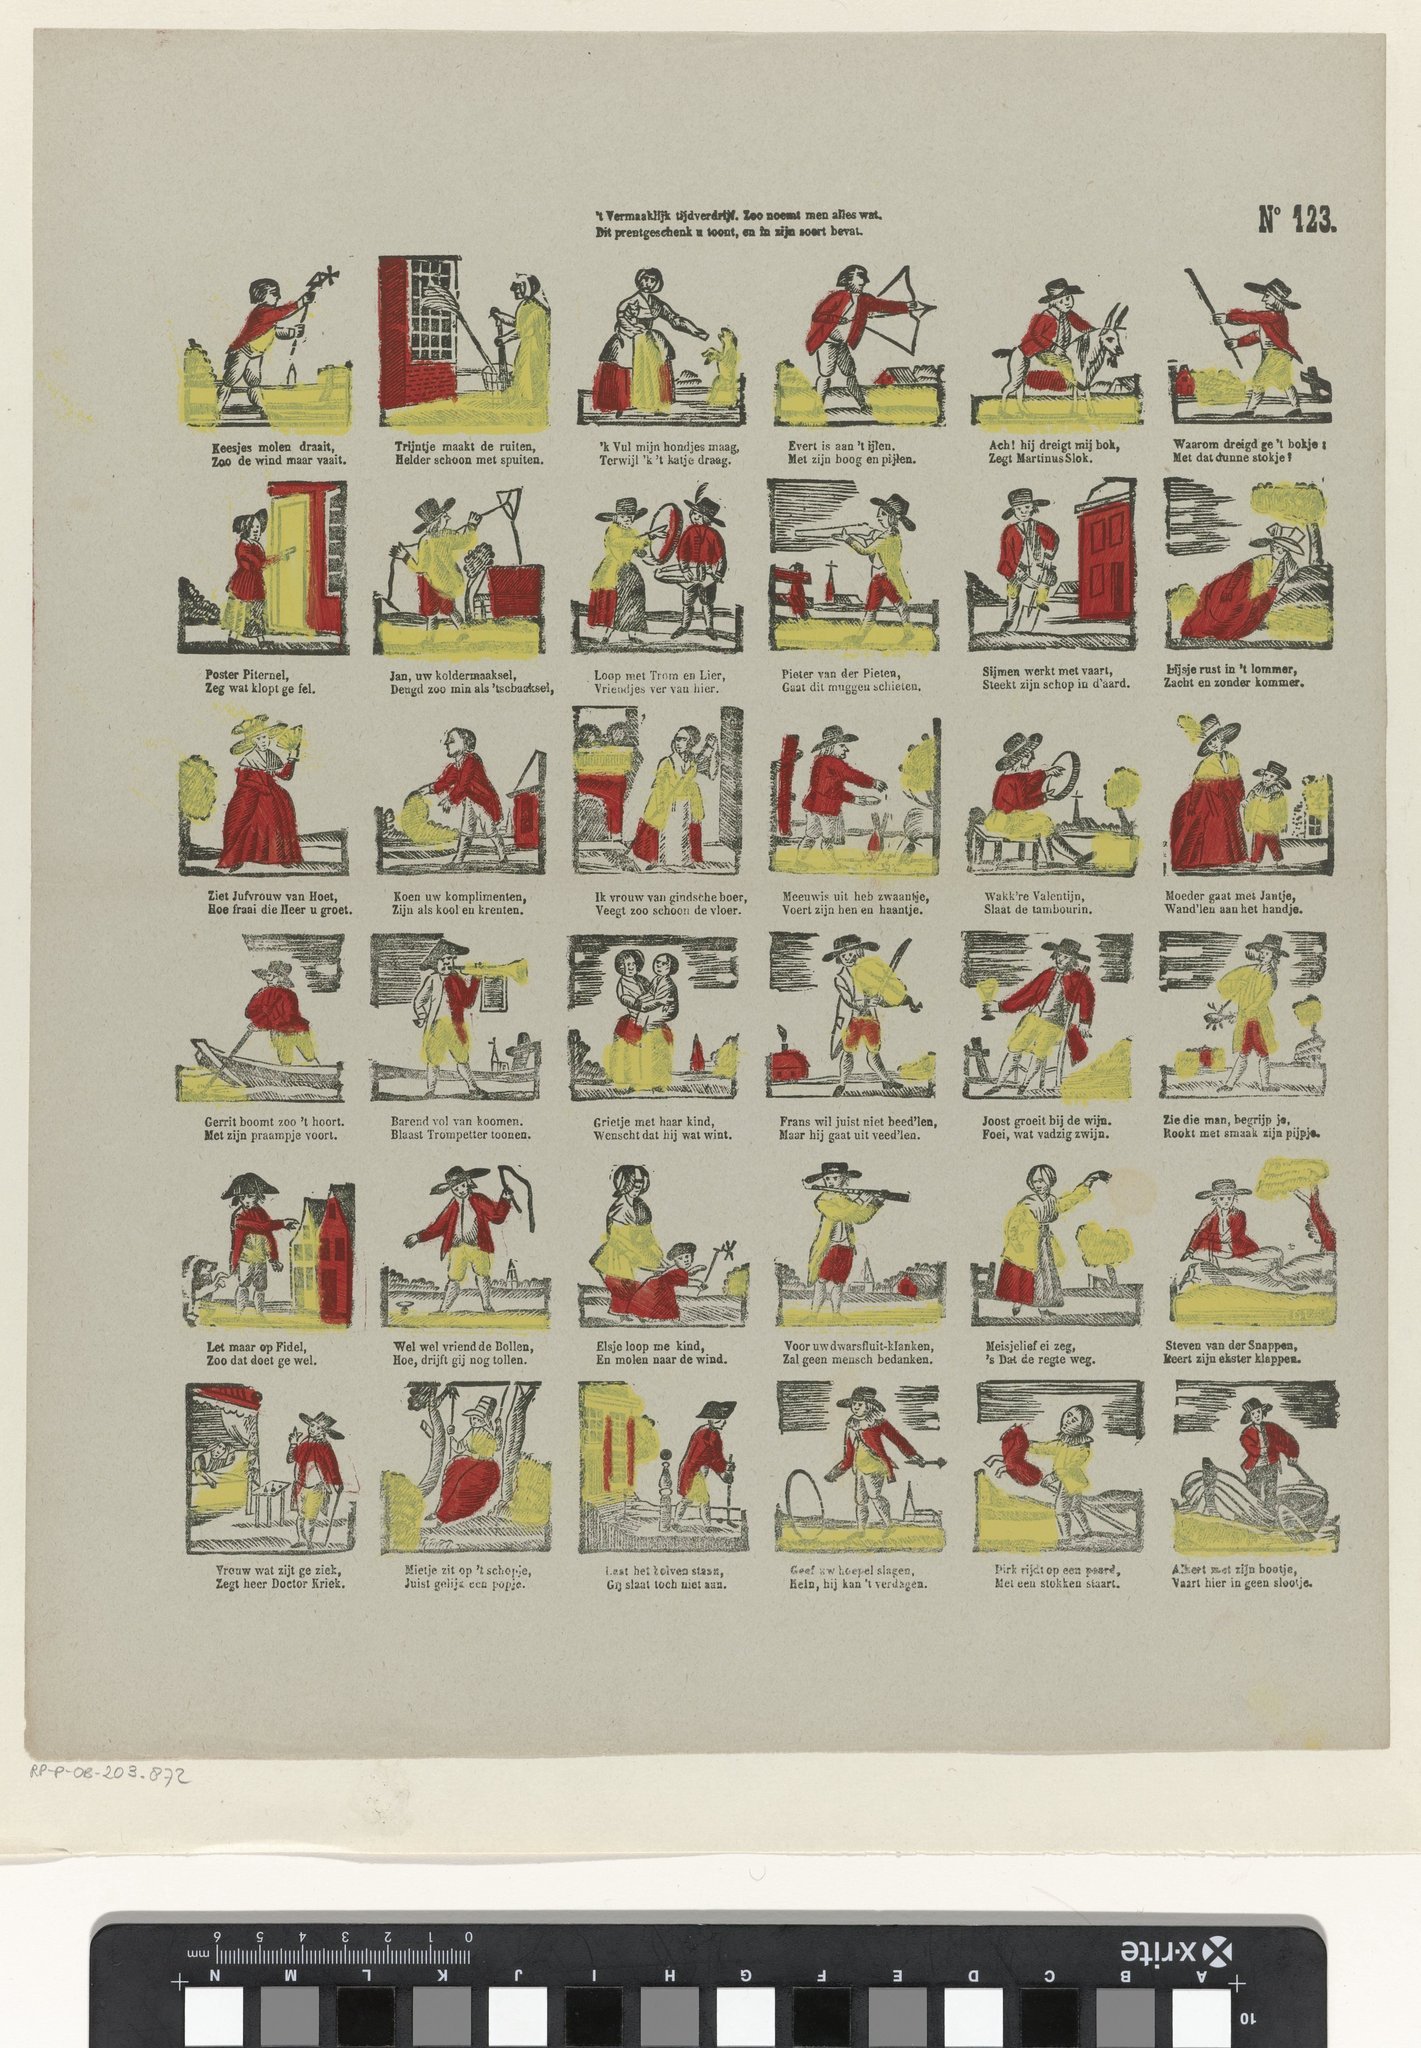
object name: print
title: 't Vermaaklijk tijdverdrijf. Zo noemt met alles wat. / Dit prentgeschenk u toont, en in zijn soort bevat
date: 1827-1894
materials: paper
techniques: colour, letterpress printing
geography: schaarbeek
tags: musician, children's games and plays, characters (human types), games using special objects (marbles, top, hoop, etc.)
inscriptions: collector's mark: Lugt 2760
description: Blad met 36 voorstellingen van spelen en bezigheden voor kinderen en volwassenen. Onder elke afbeelding een tweeregelig vers. Genummerd rechtsboven: No 123.